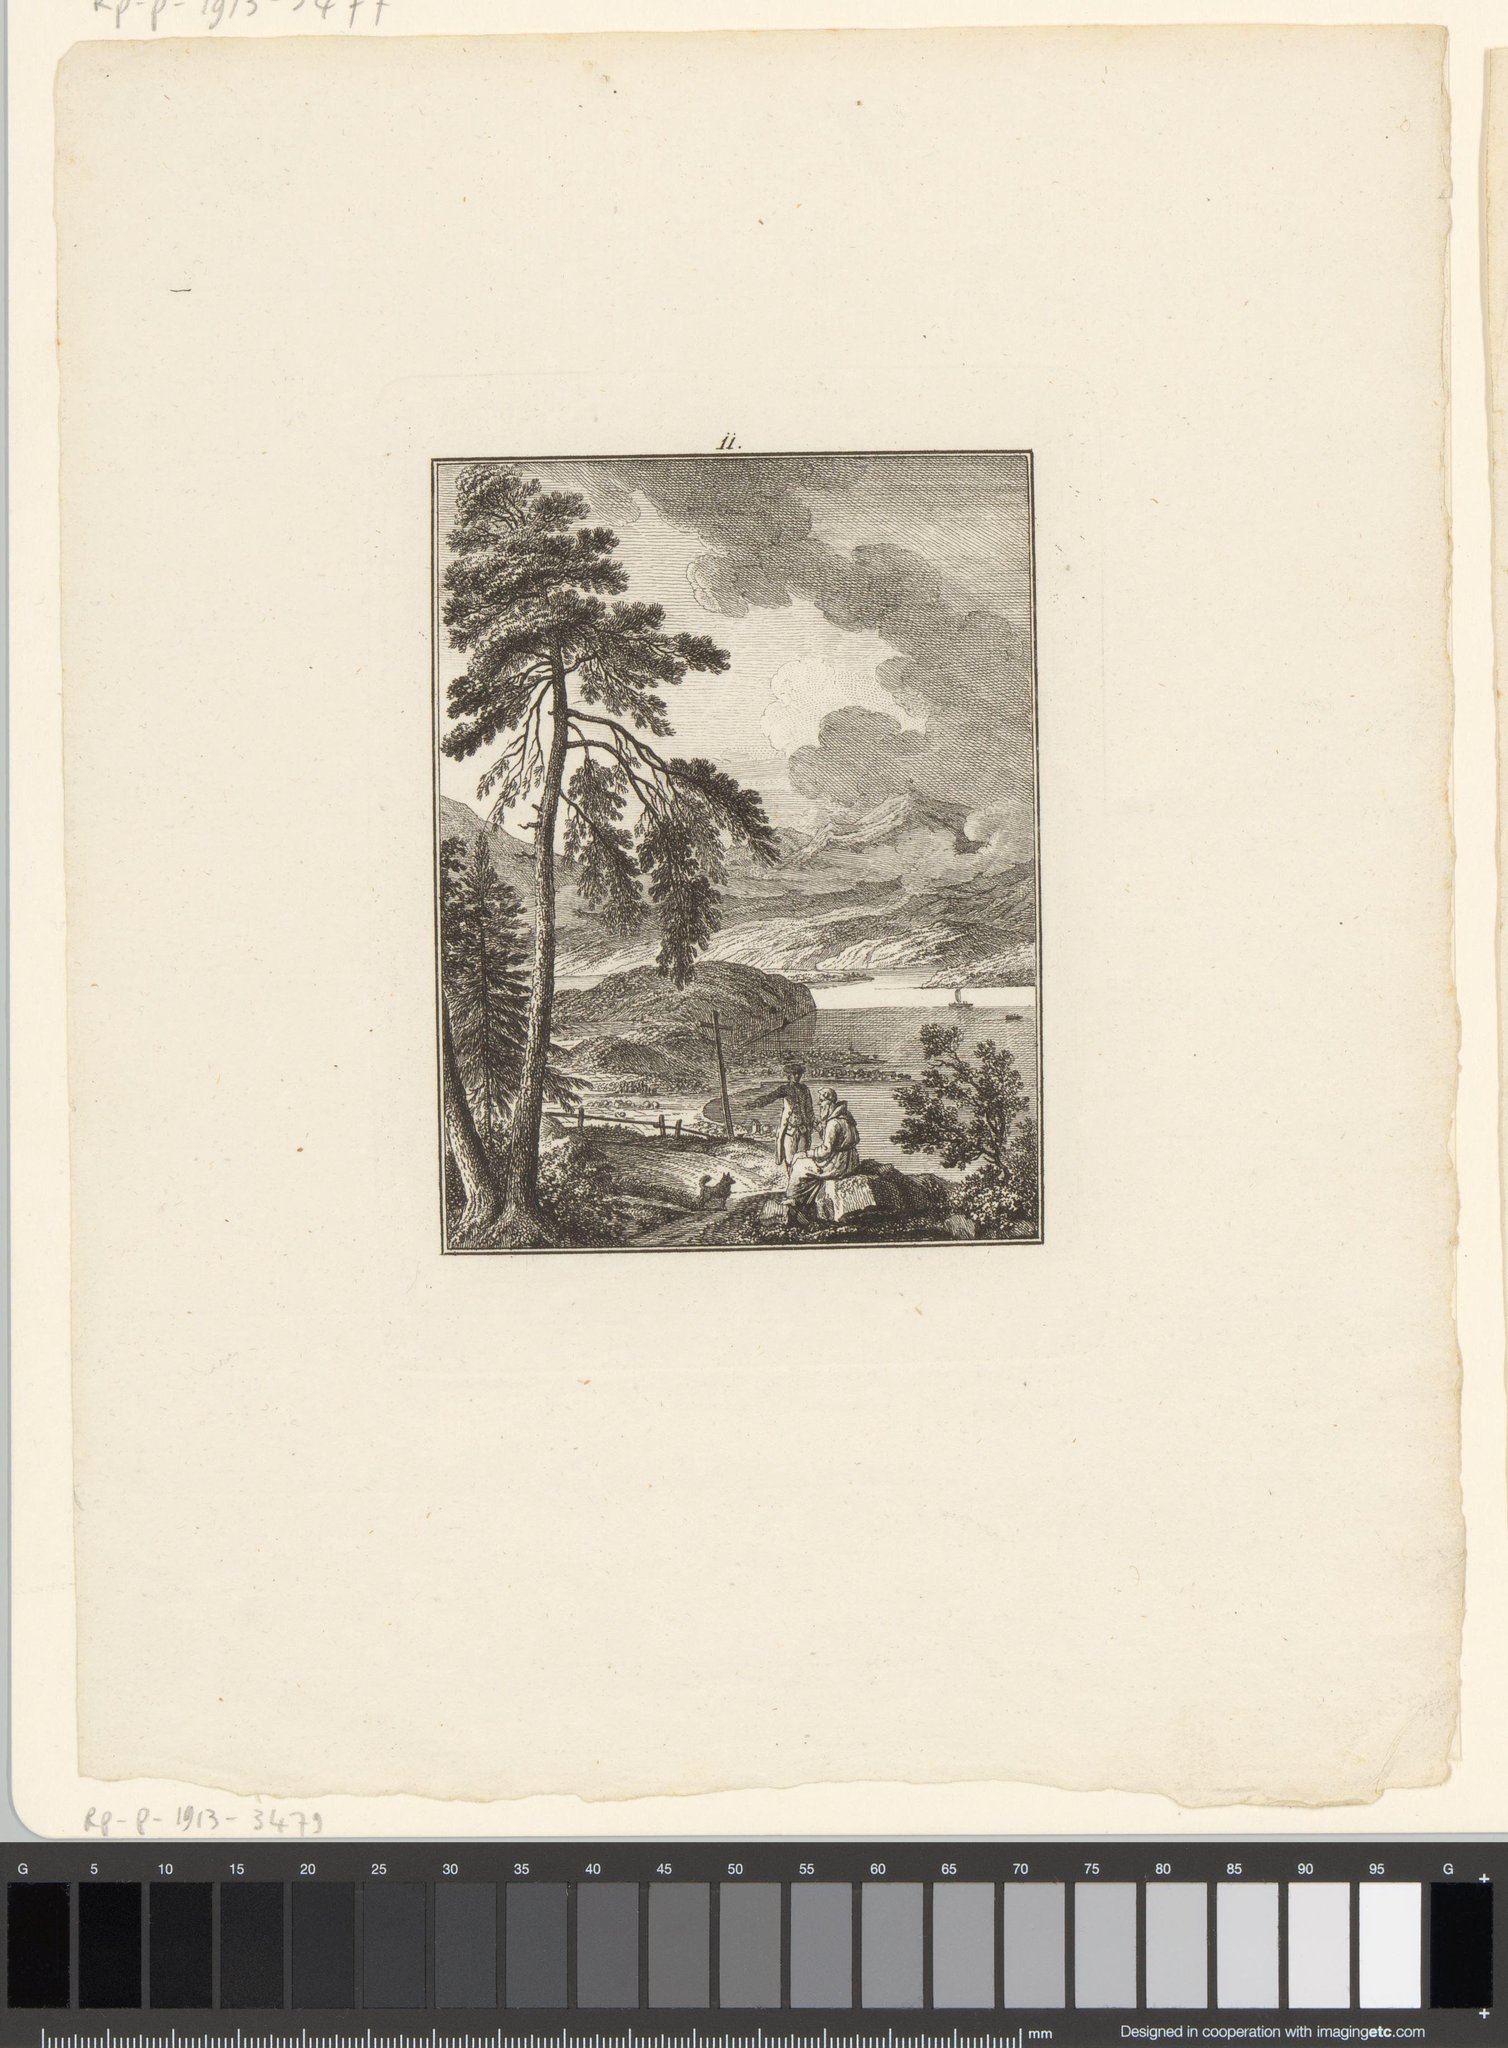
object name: print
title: Landschappen met water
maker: johann rudolph schellenberg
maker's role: print maker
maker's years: 1740-1806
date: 1781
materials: paper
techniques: etching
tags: landscapes with waters, waterscapes, seascapes (in the temperate zone), traveller(s) attacked by robber(s)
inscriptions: collector's mark: Lugt 2228